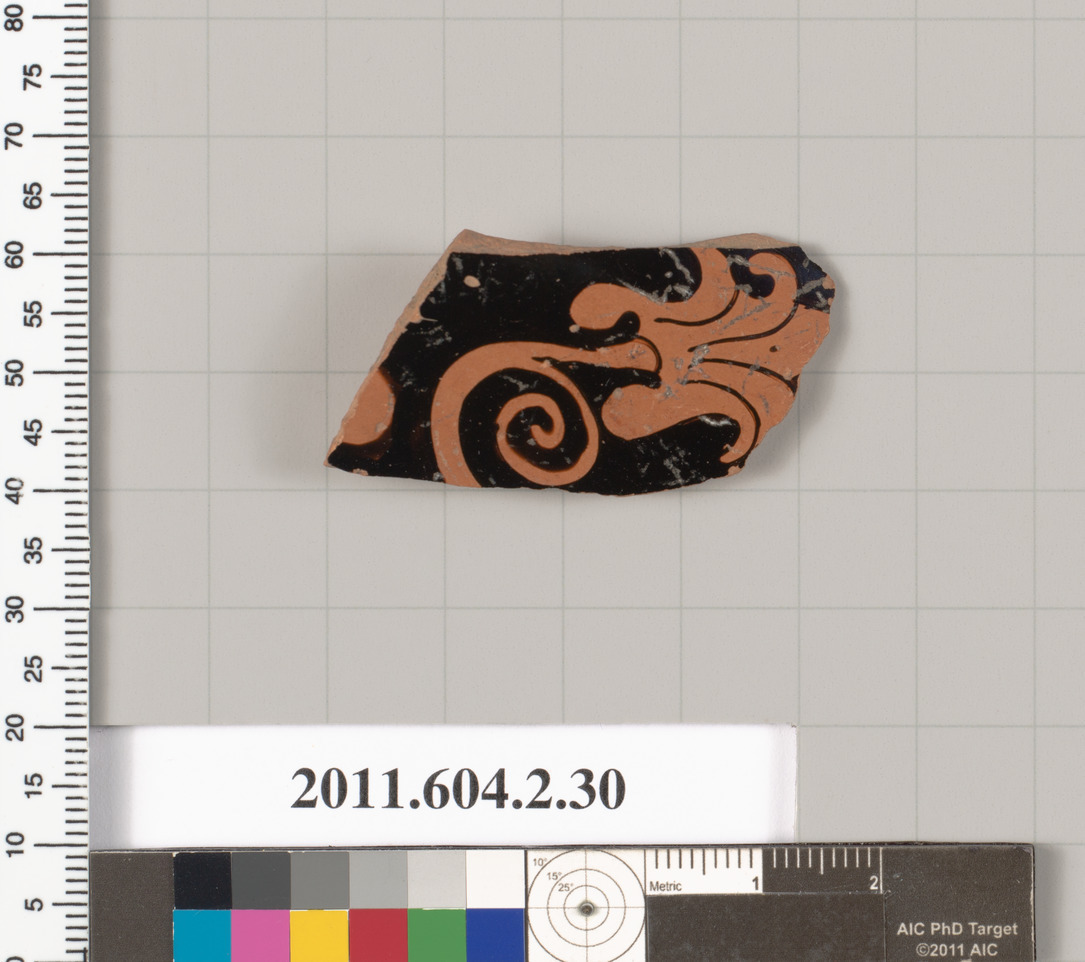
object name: psykter fragment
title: Terracotta fragment of a psykter (vase for cooling wine)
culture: greek, attic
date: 534-468 BCE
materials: terracotta